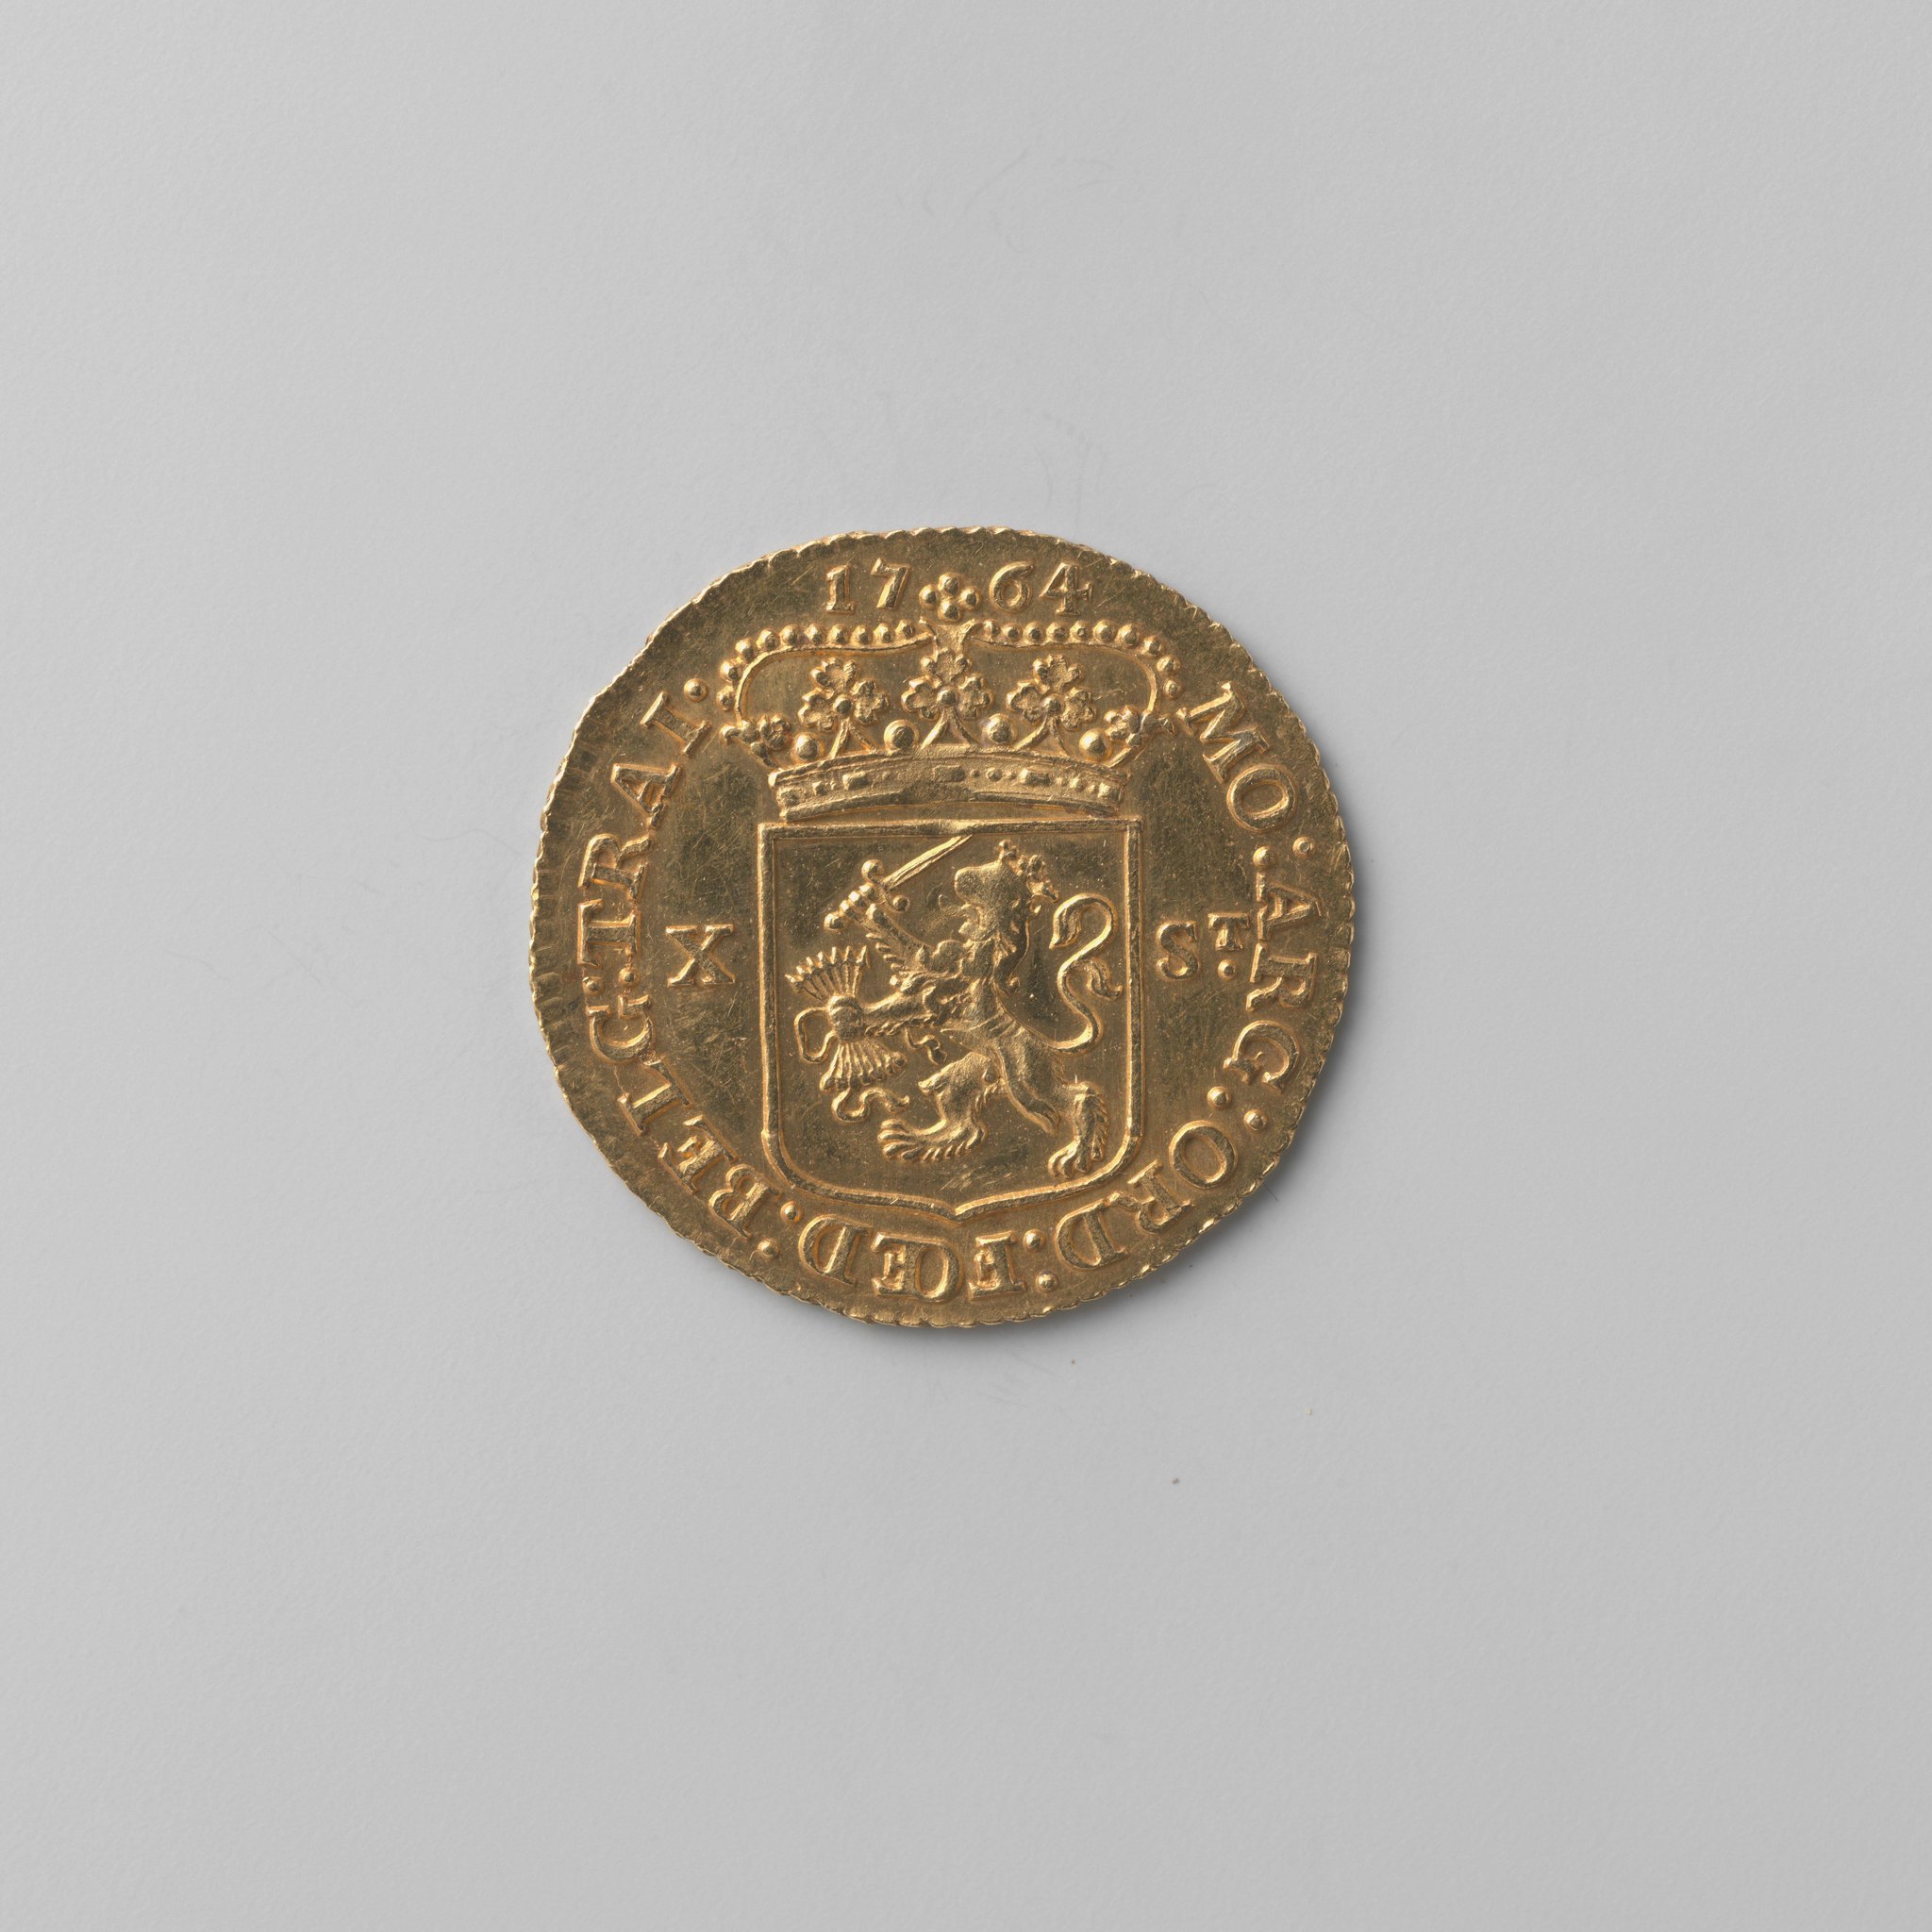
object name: coin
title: Utrecht, halve gulden, 1764. Afslag in goud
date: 1764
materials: gold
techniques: striking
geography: utrecht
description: Gouden munt. Voorzijde: tussen waarde-aanduiding X St gekroond generaliteitswapenschild. Jaartal boven kroon. Keerzijde: Nederlandse maagd met vrijheidshoed en speer, leunend op een bijbel op een altaar. Kabelrand. Afslag in goud.